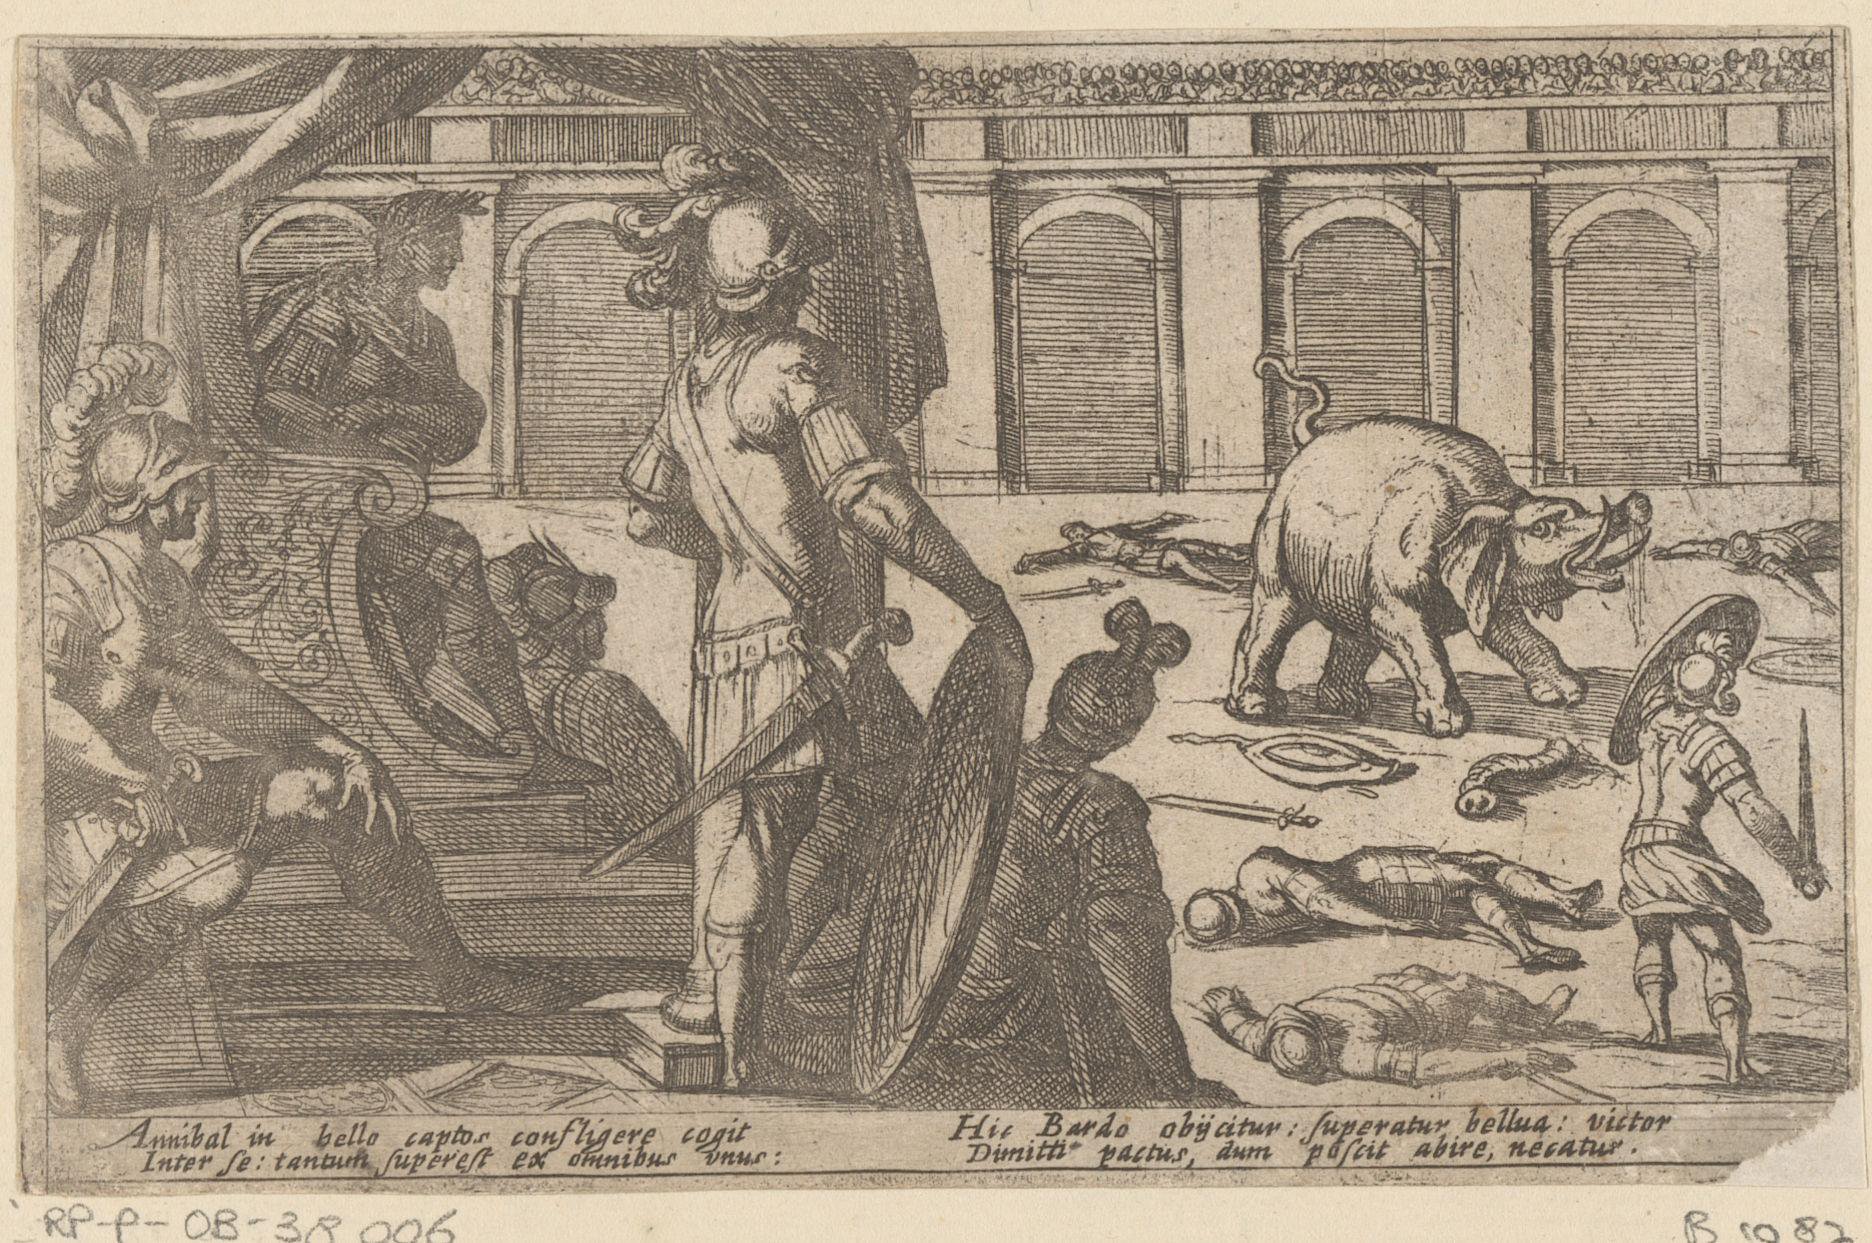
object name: print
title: Venationes Ferarum, Avium, Piscium Pugnae bestiariorum: et mutuae bestiarum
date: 1602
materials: paper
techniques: etching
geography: italy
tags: fight between man and animal, fight of gladiators, trunked animals: elephant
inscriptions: collector's mark: Lugt 240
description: Gezicht in een arena waar een gladiator vecht met een olifant. Rondom de olifant liggen vier dode gladiatoren. Op de voorgrond links zit de Romeinse keizer op zijn troon. Tekst in het Latijn in ondermarge.